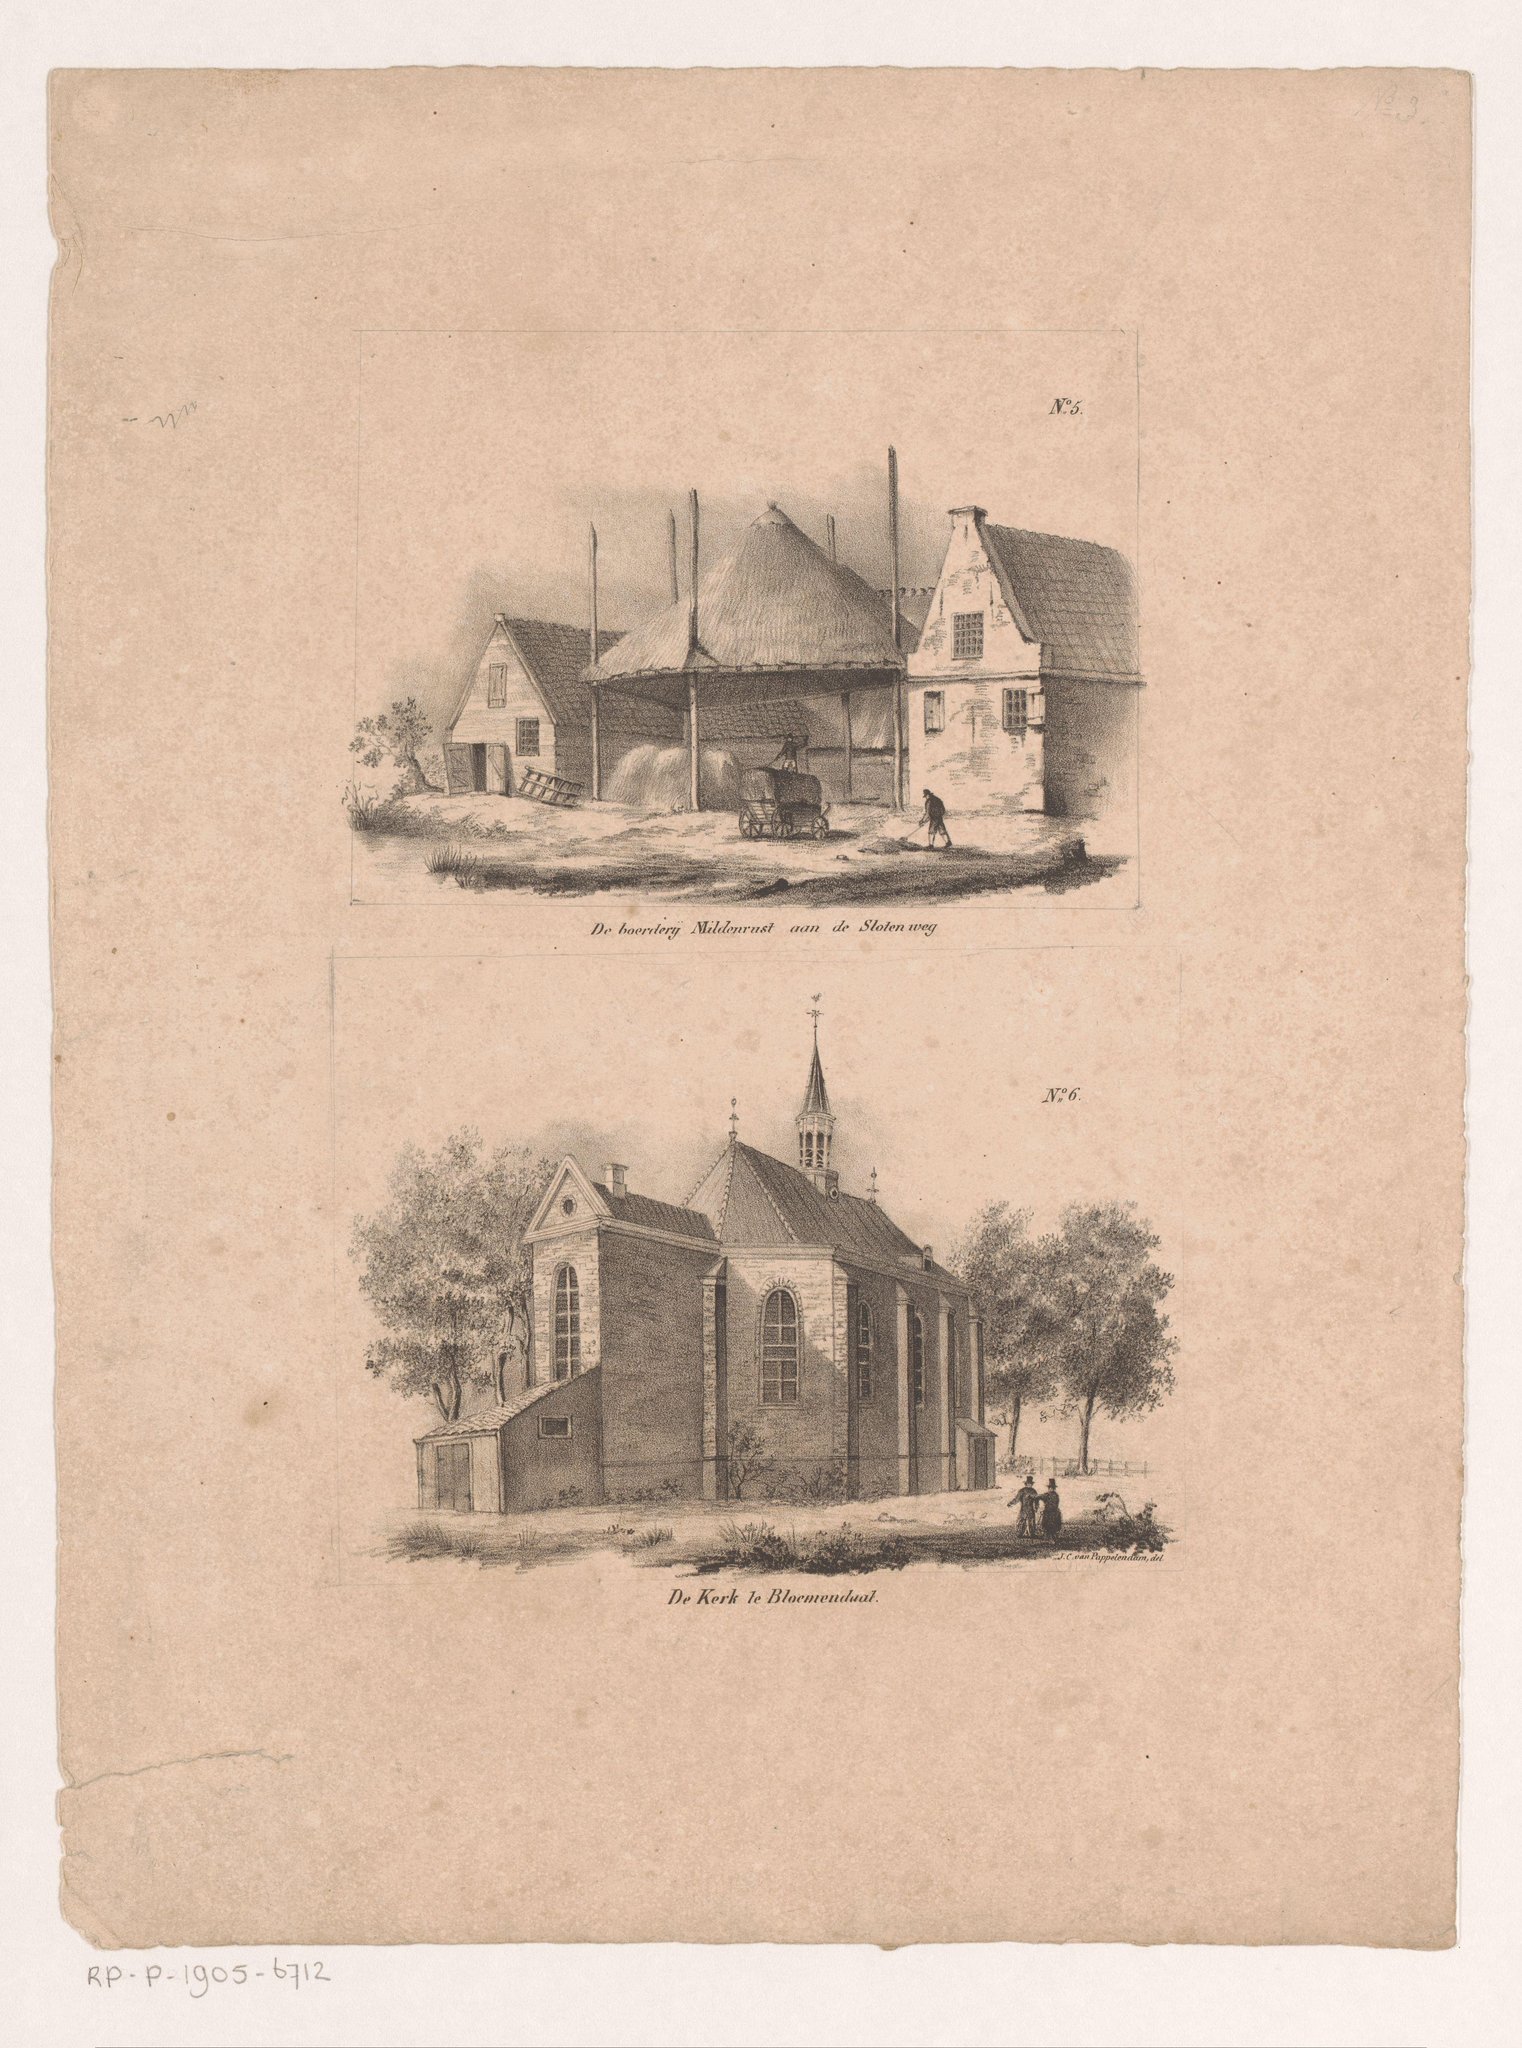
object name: print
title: Gezichten in de omgeving van Amsterdam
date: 1825-1845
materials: paper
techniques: lithograph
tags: bloemendaal, sloterweg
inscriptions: collector's mark: Lugt 2228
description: Gezichten op boerderij Mildenrust en de kerk van Bloemendaal.